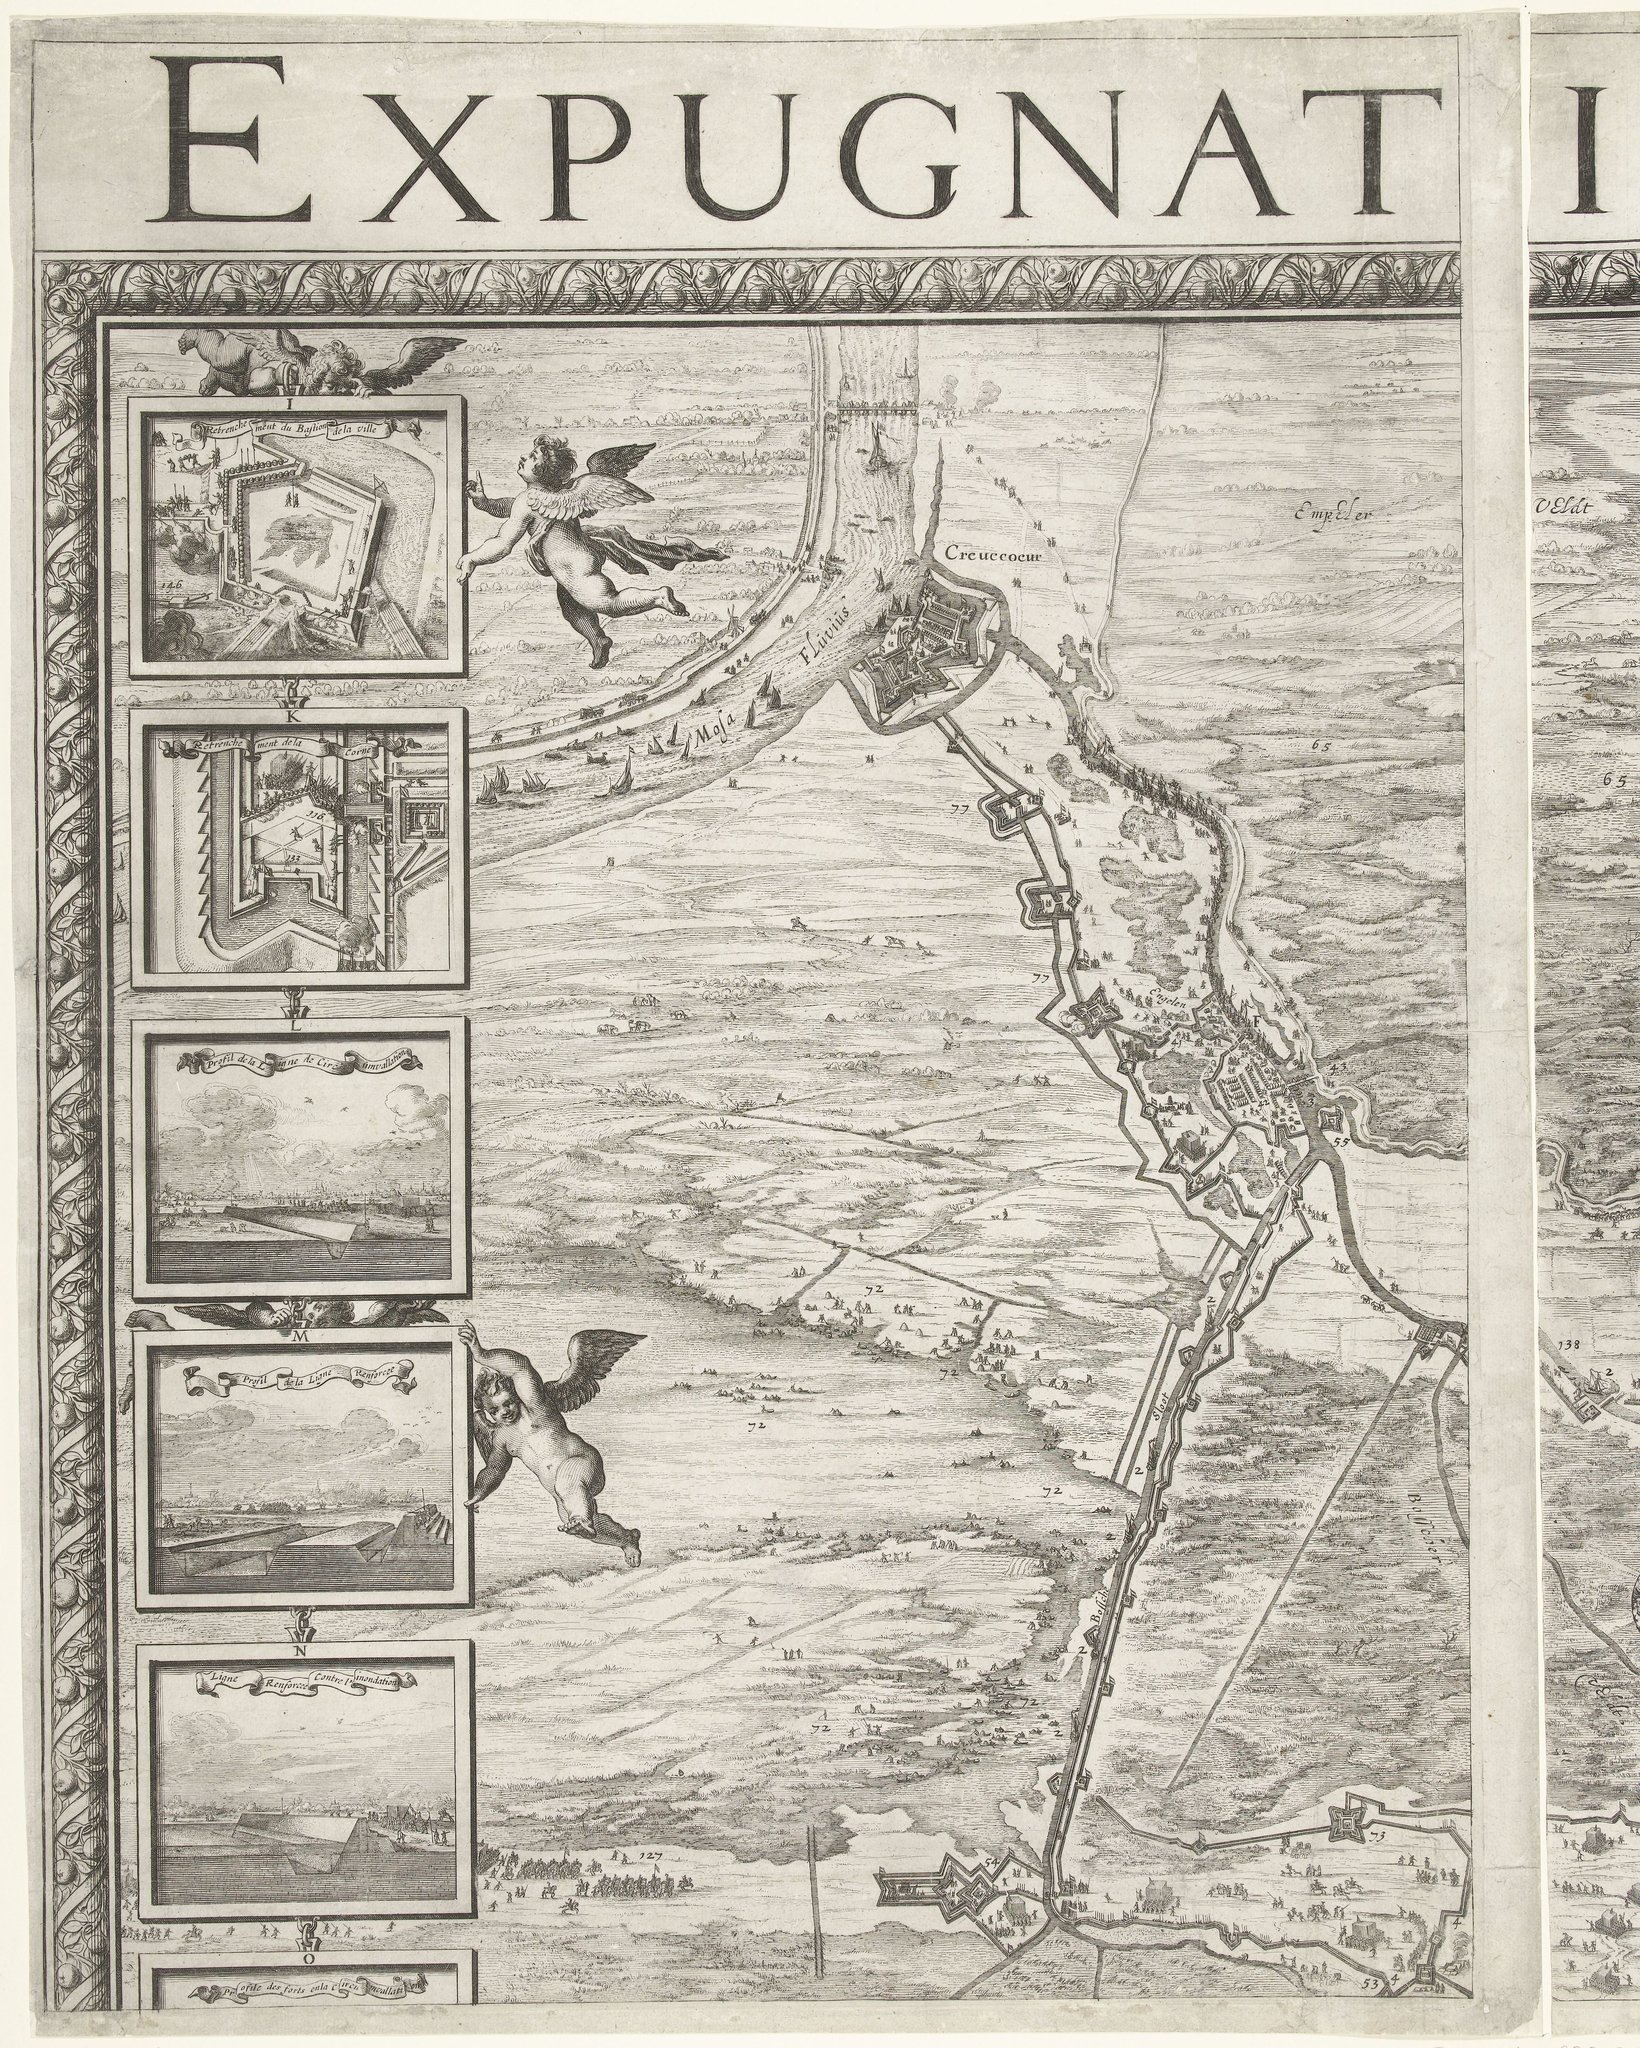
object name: print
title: Siege of Den Bosch in 1629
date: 1629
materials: paper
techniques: etching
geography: northern netherlands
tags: delft, the hague, frederick henry (prince of orange), maps of separate countries or regions, siege, position war, den bosch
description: After a four-and-a-half month siege Den Bosch surrenders to Frederick Henry on 14 September 1629. The Spanish troops withdraw from the city, and Den Bosch becomes part of the Republic. The city was entirely encircled by a 45-kilometer line. Marshes are reclaimed, trenches dug, dikes thrown up, and ramparts control the access roads. The magnitude of this enterprise, paid for by the proceeds of the Silver Fleet, is recorded in this triumphal map.